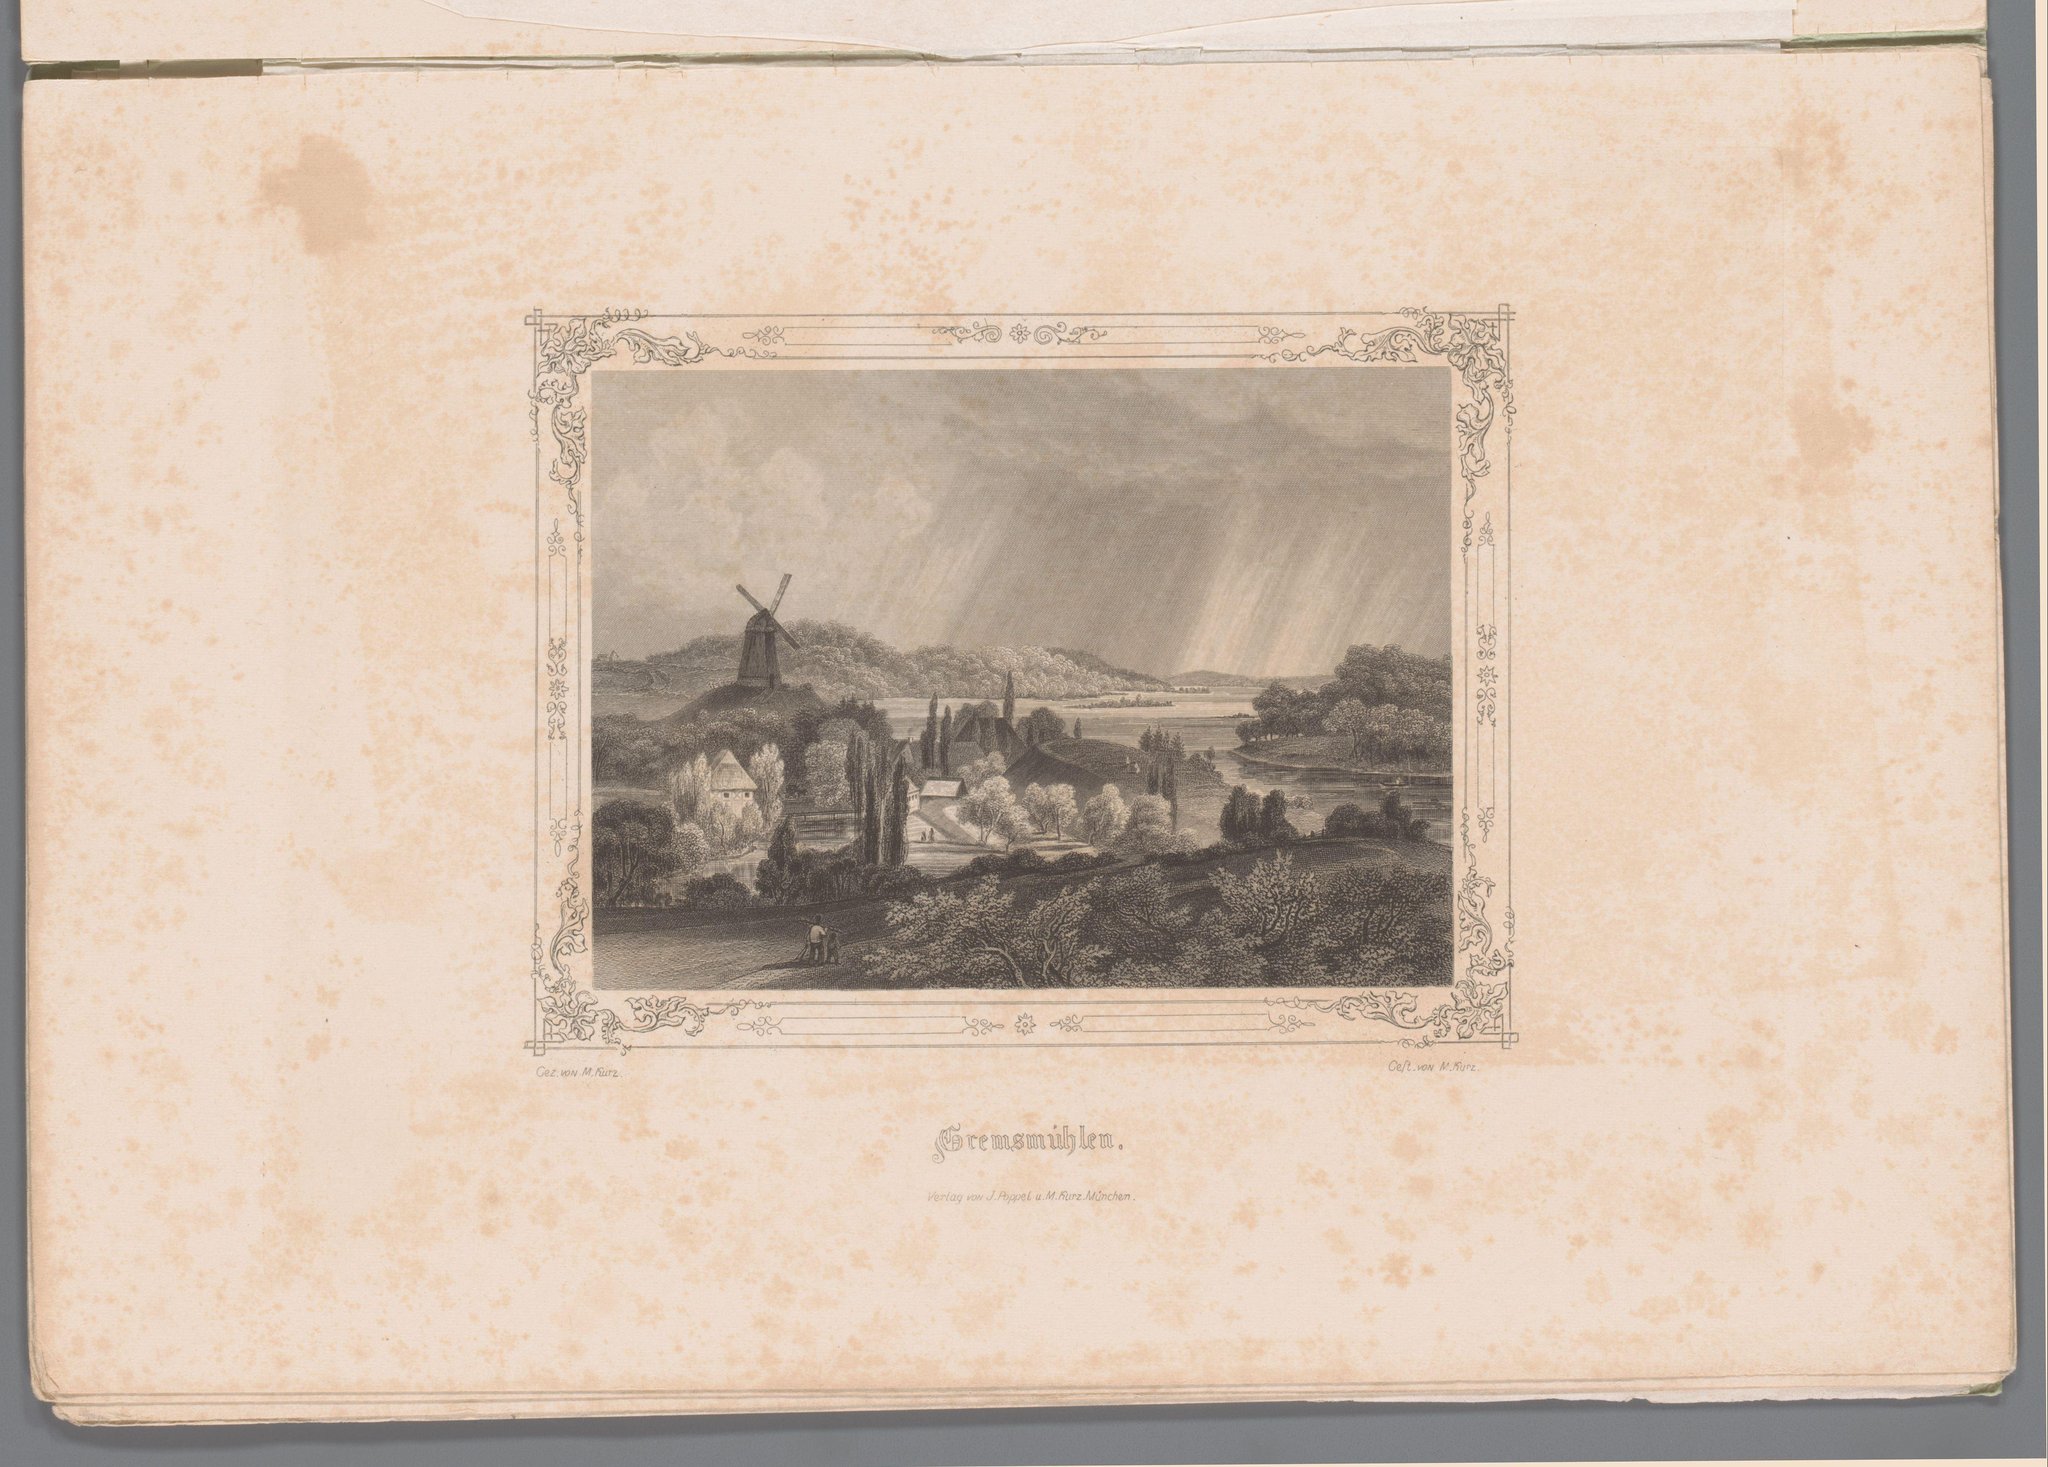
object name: print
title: Gezicht op een molen bij Malente-Gremsmühlen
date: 1847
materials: paper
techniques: engraving, etching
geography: munich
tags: lake, windmill in landscape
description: Deze prent behoort tot deel drie of vier van de serie 'Landschappen in Sleeswijk-Holstein'. Het betreft een vierdelige reeks uitgegeven in twee omslagen waarvan deze omslag deel drie en vier bevat met daarin zes landschappen en zes tekstbladen.